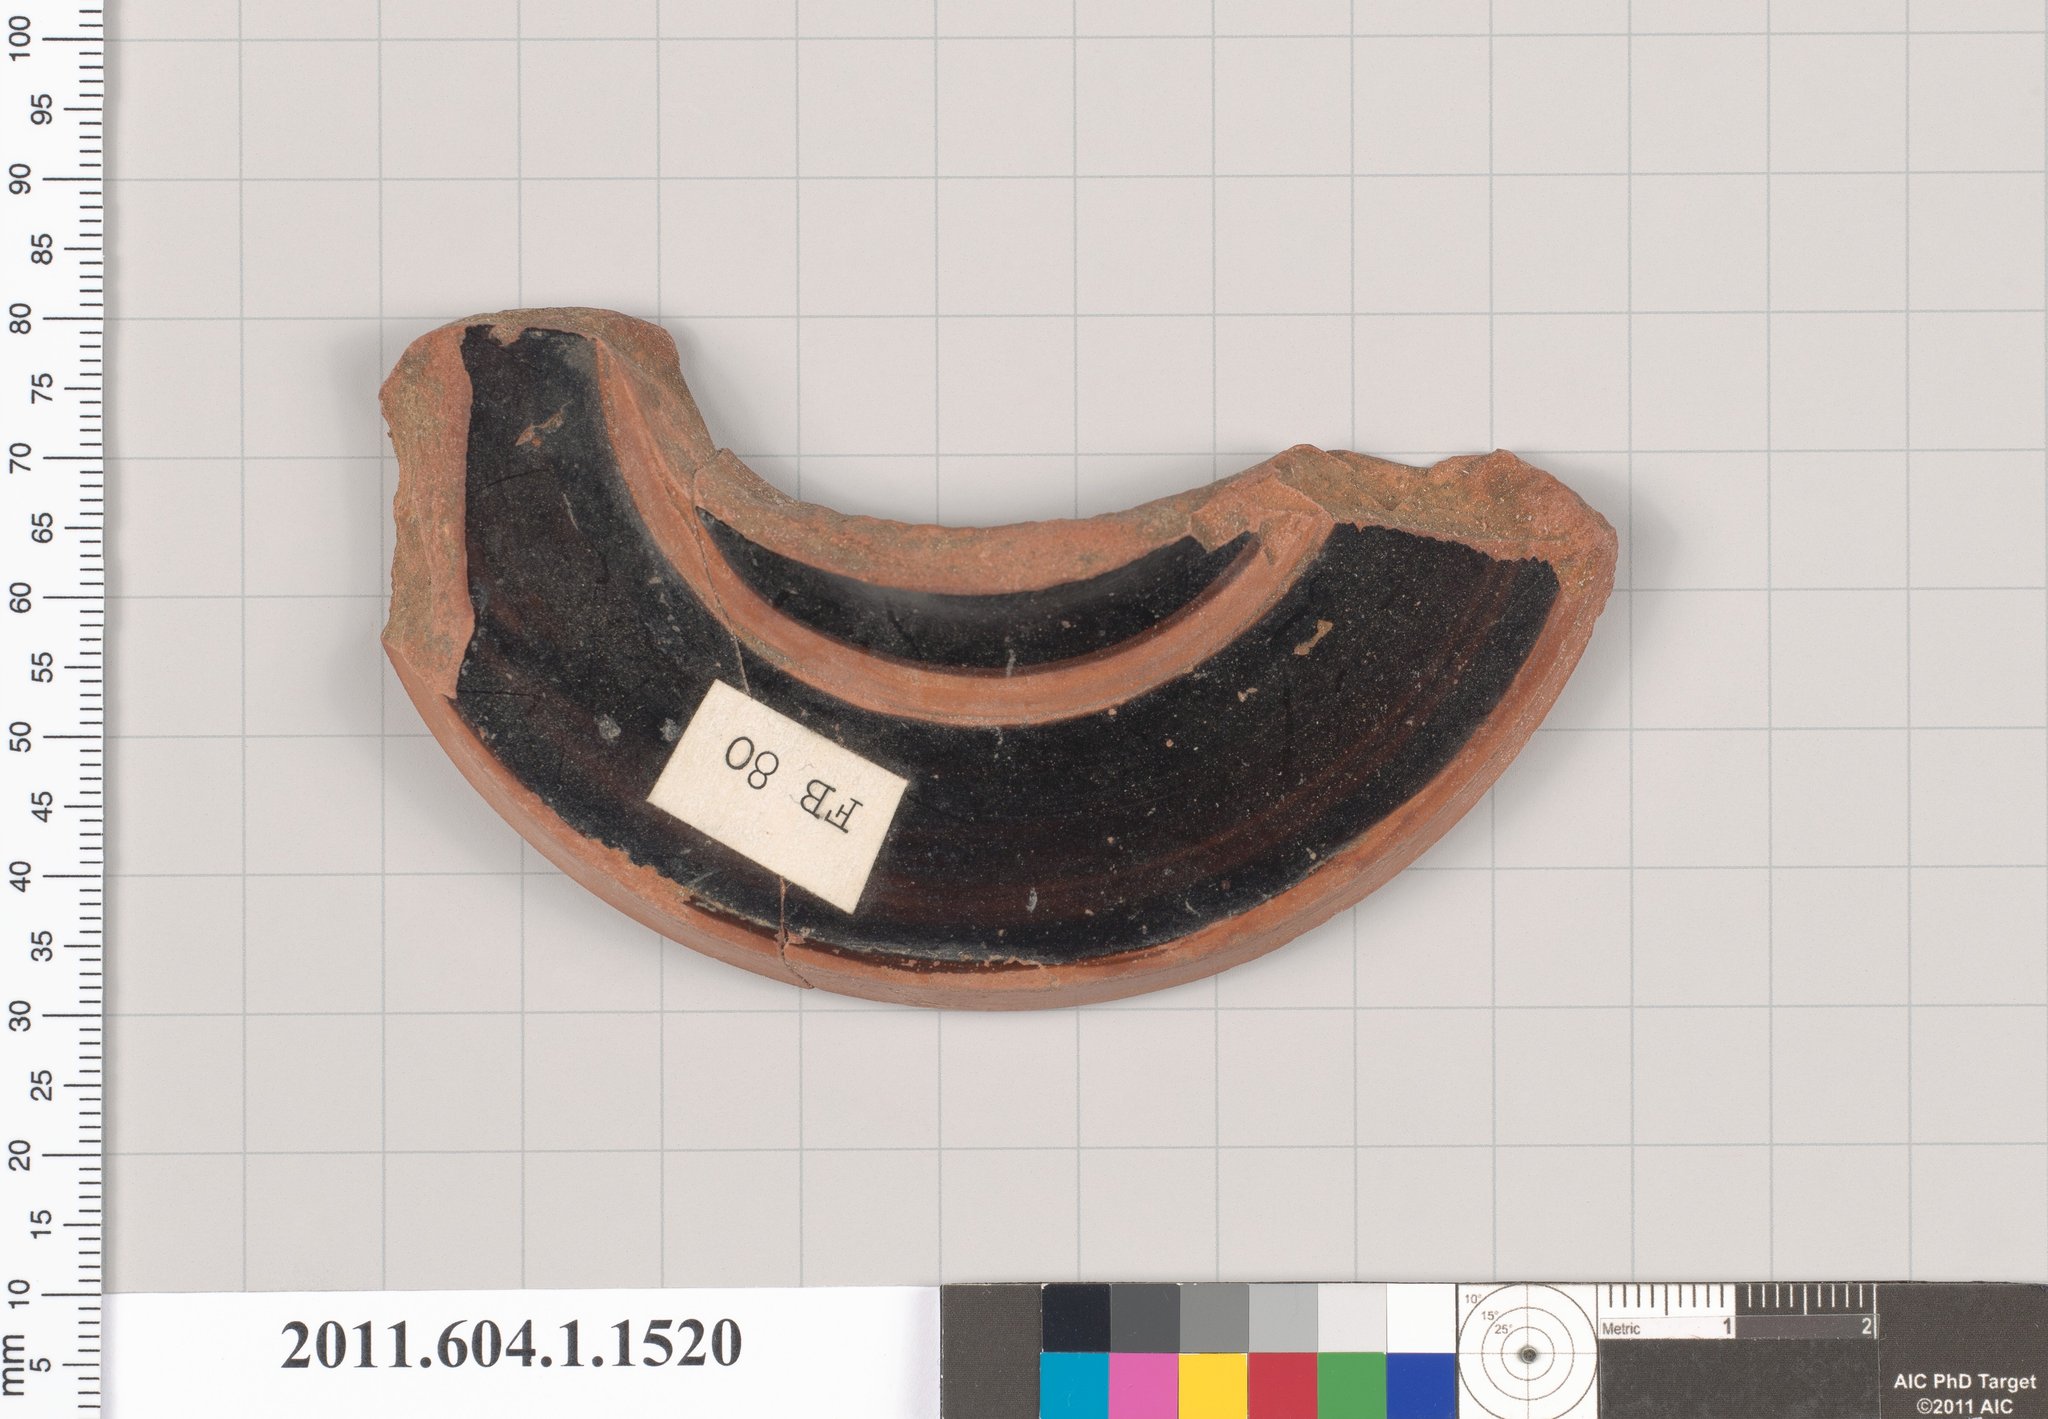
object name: kylix fragment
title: Terracotta fragment of a kylix (drinking cup)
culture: greek, attic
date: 500-401 BCE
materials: terracotta